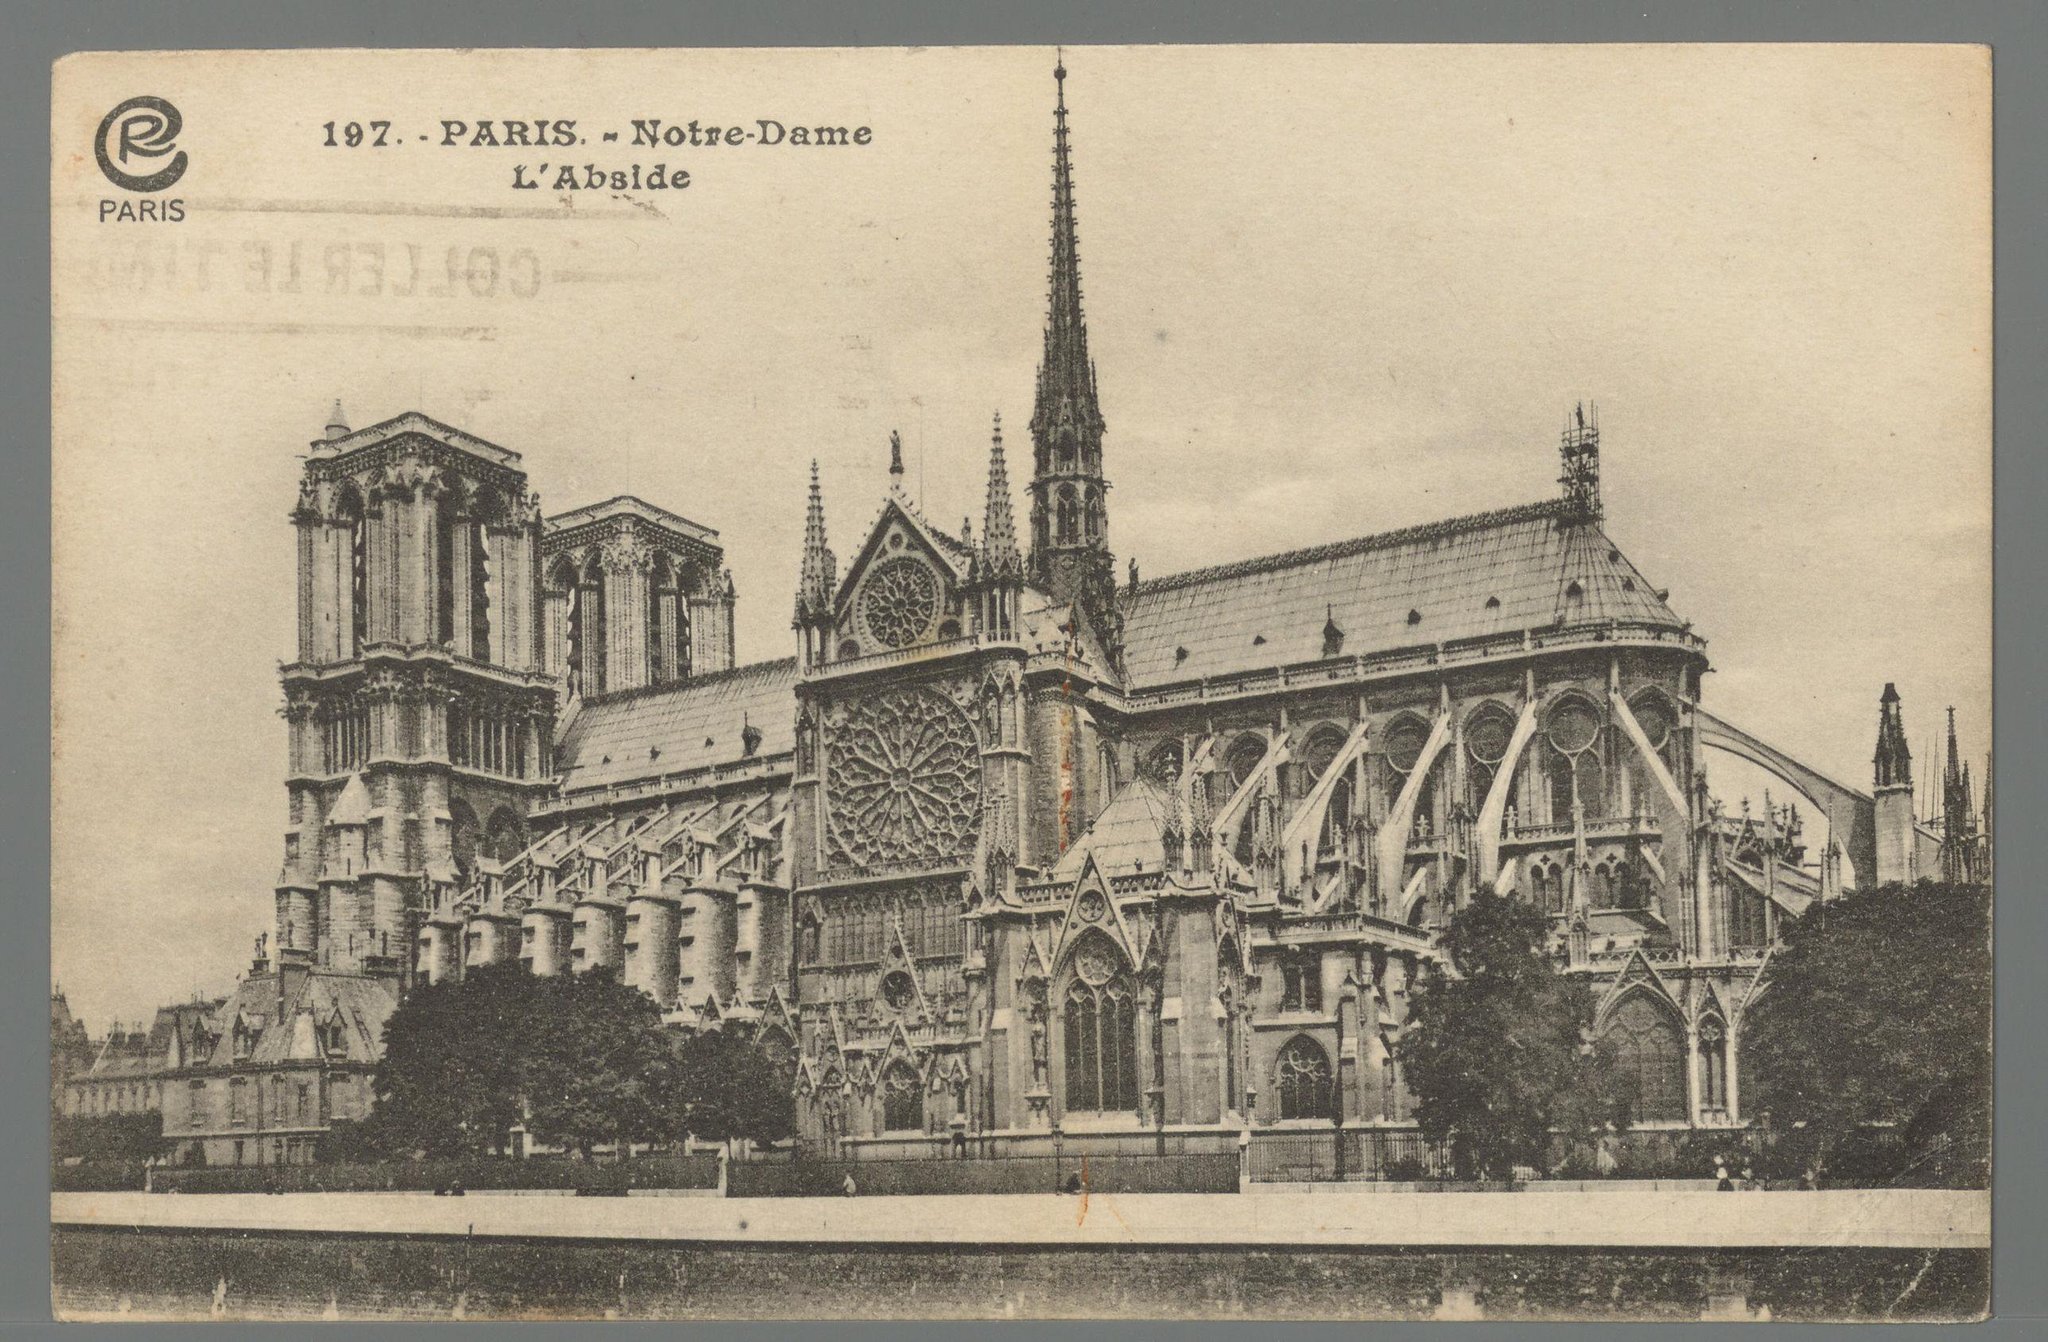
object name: ansichtkaart, prentbriefkaart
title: Paris - Notre-Dame. L'Abside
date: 1911-1936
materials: cardboard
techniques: photograph, writing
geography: nancy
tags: church (exterior)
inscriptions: monogram: ‘CR Paris’, postage stamp